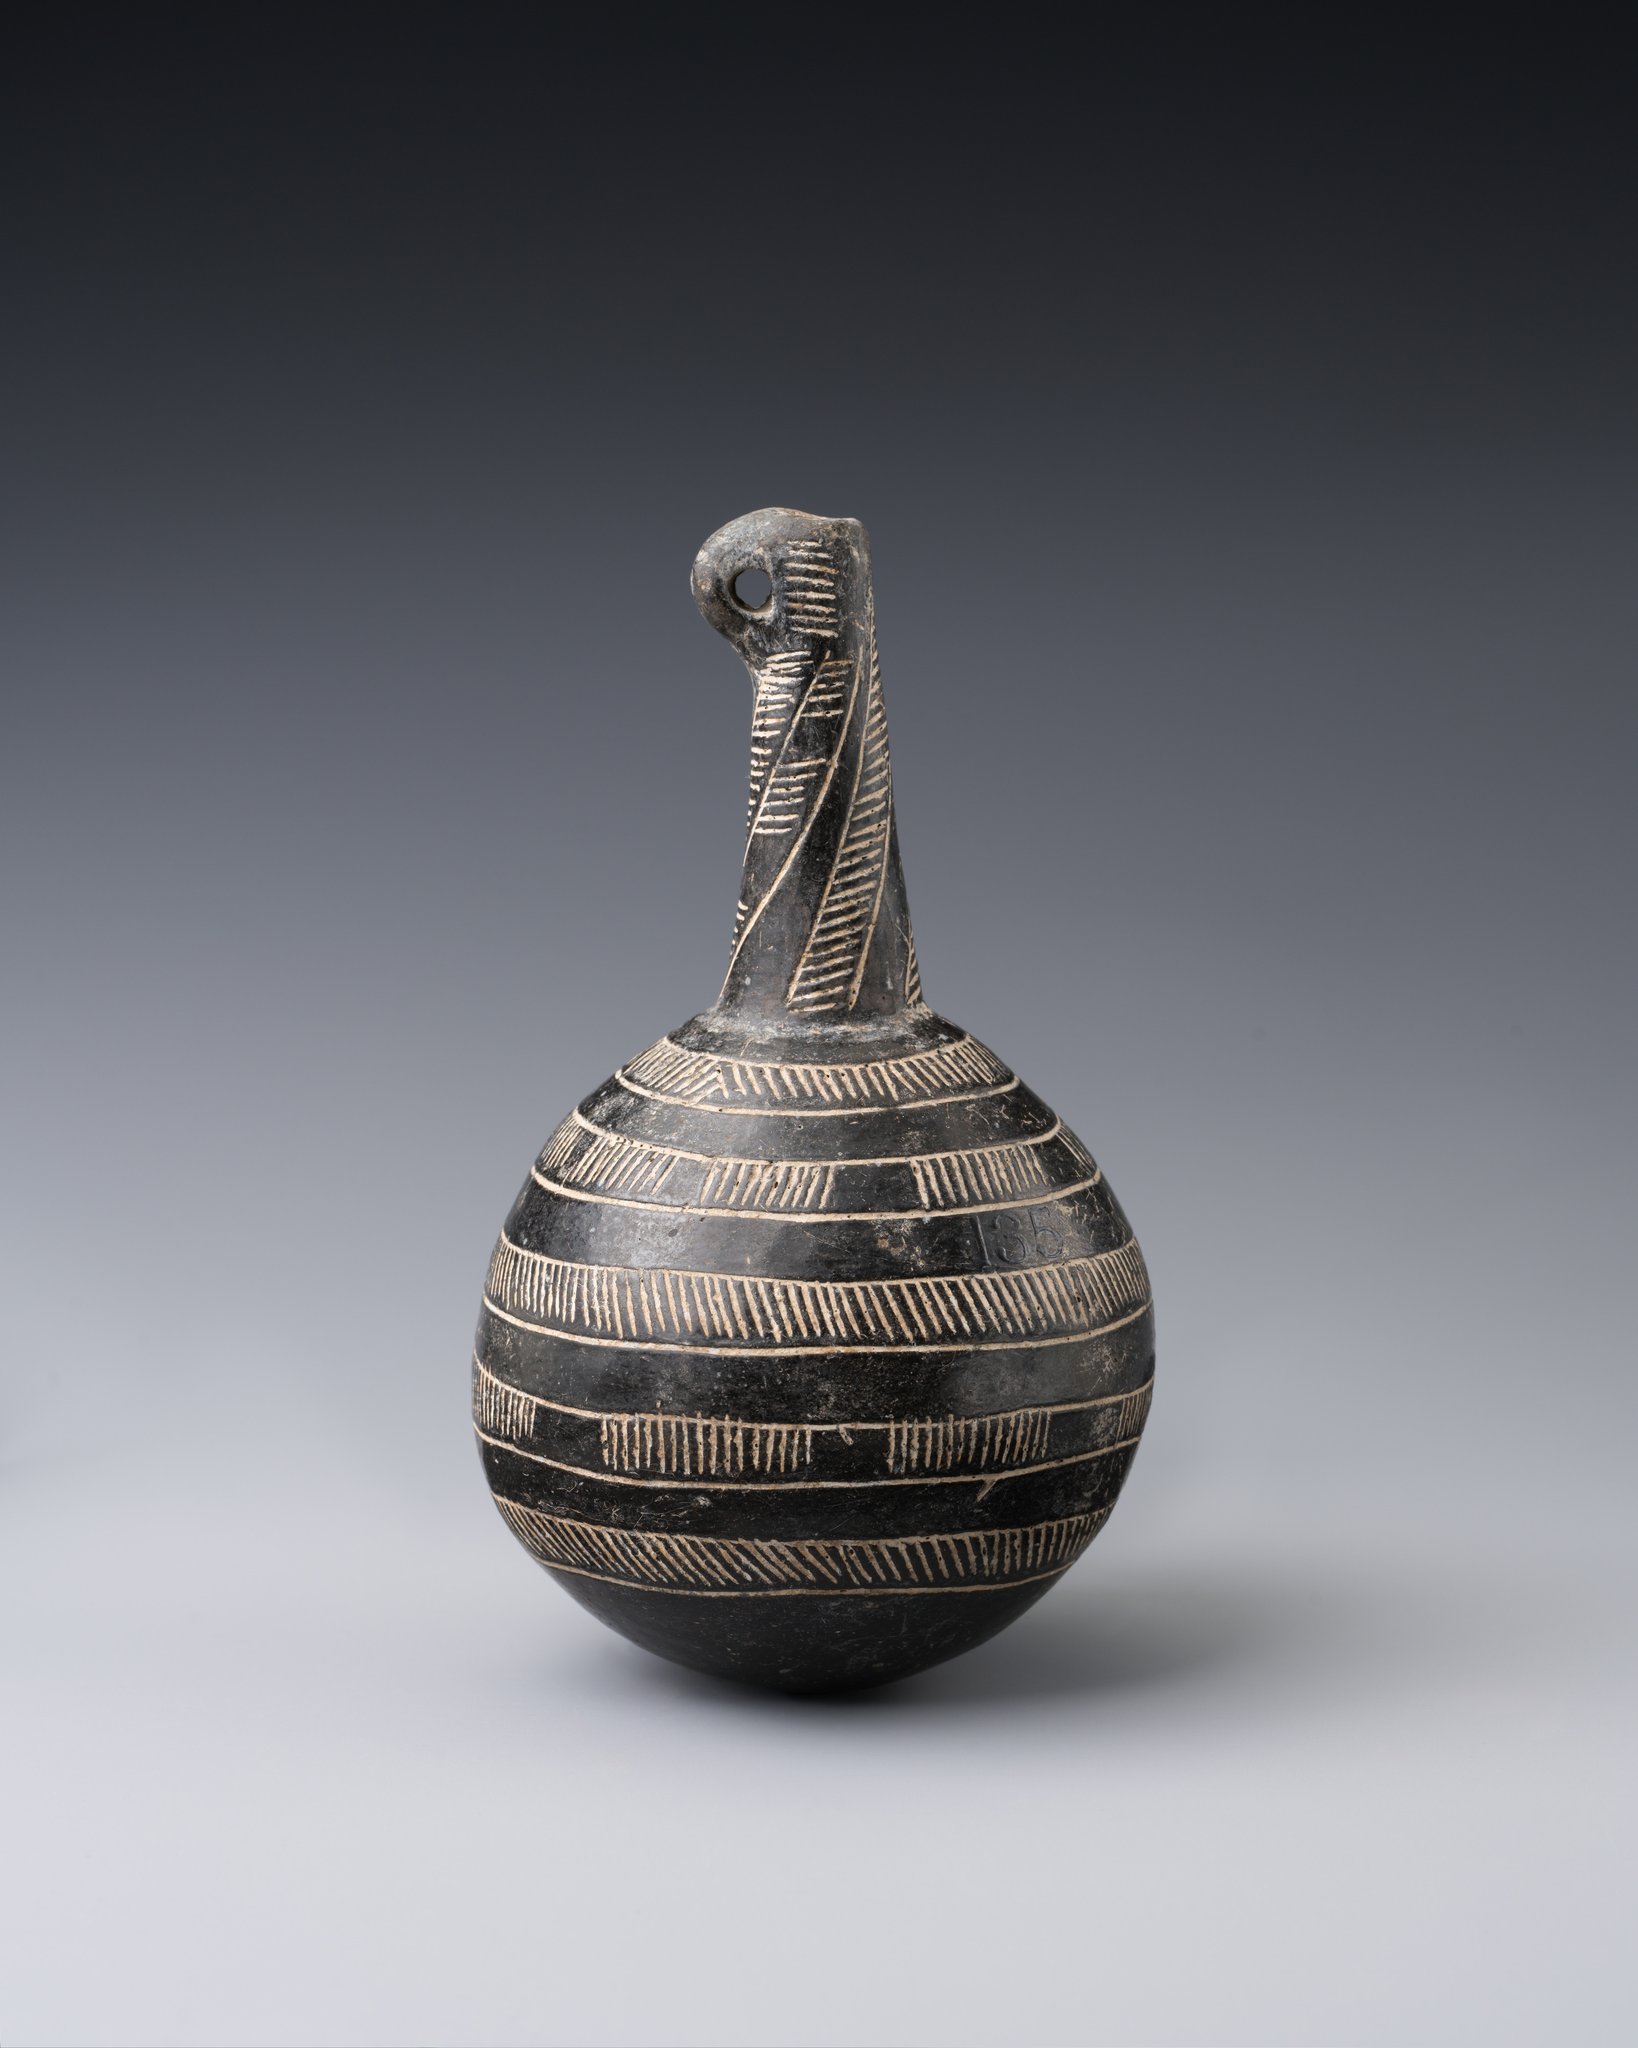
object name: bottle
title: Terracotta bottle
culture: cypriot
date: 1900-1725 BCE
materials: terracotta